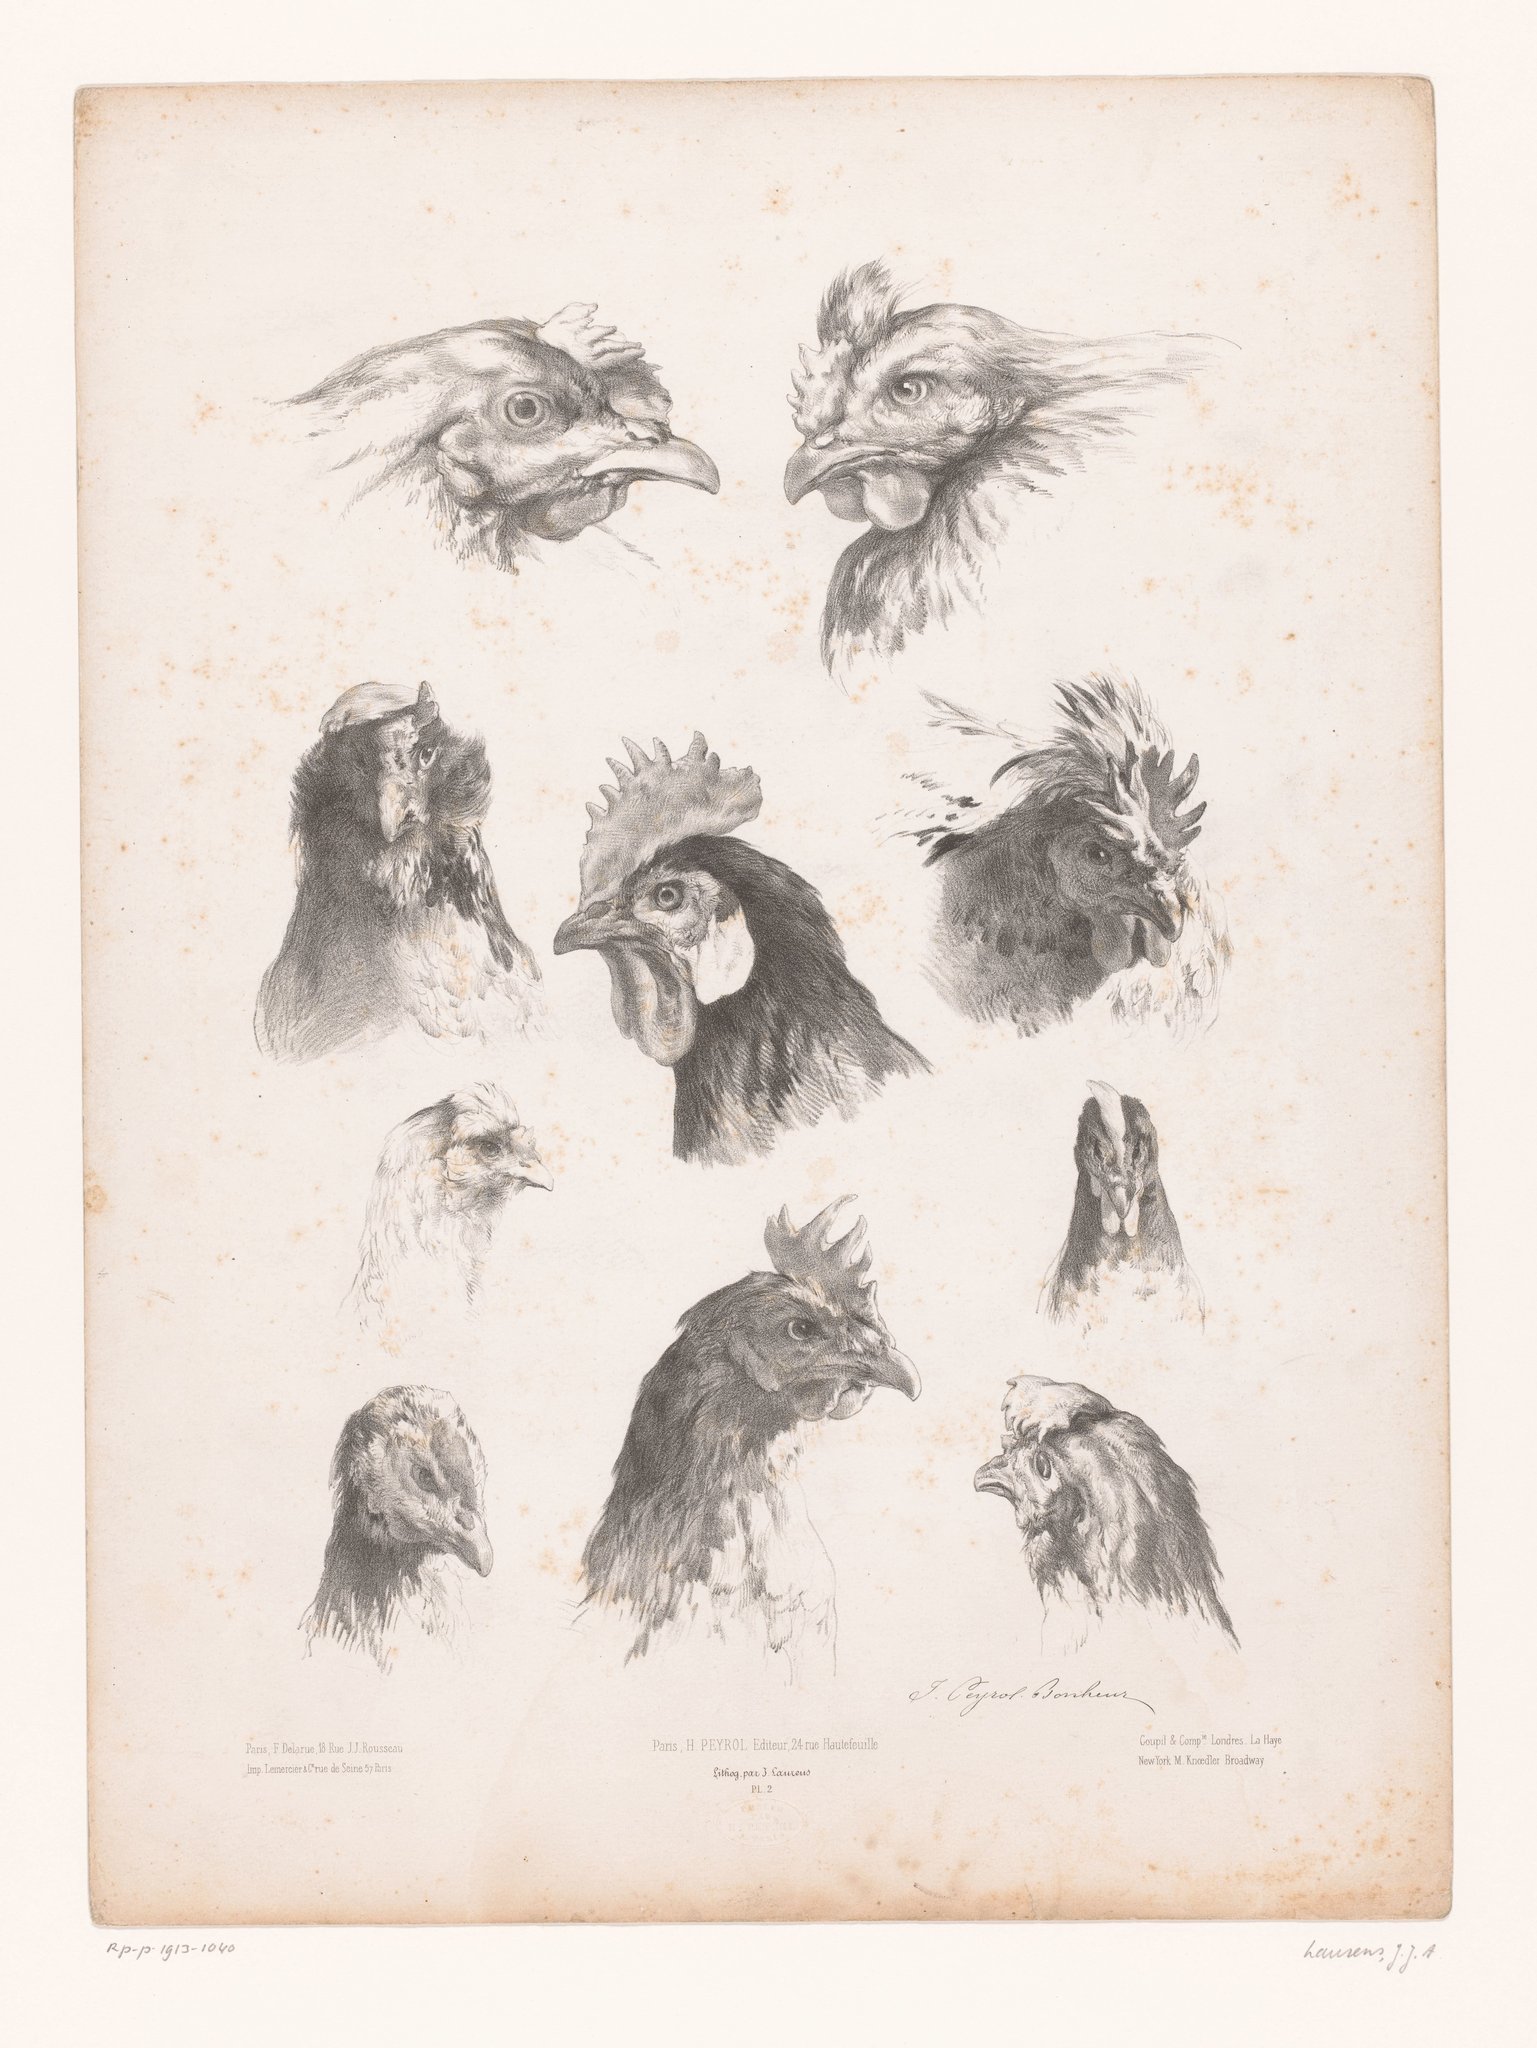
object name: print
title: Dierstudies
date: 1865-1878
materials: paper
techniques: lithograph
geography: new york city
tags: fowl (cock, hen, chicken, etc.)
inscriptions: check stamp: Lugt 4777, collector's mark: Lugt 2228a